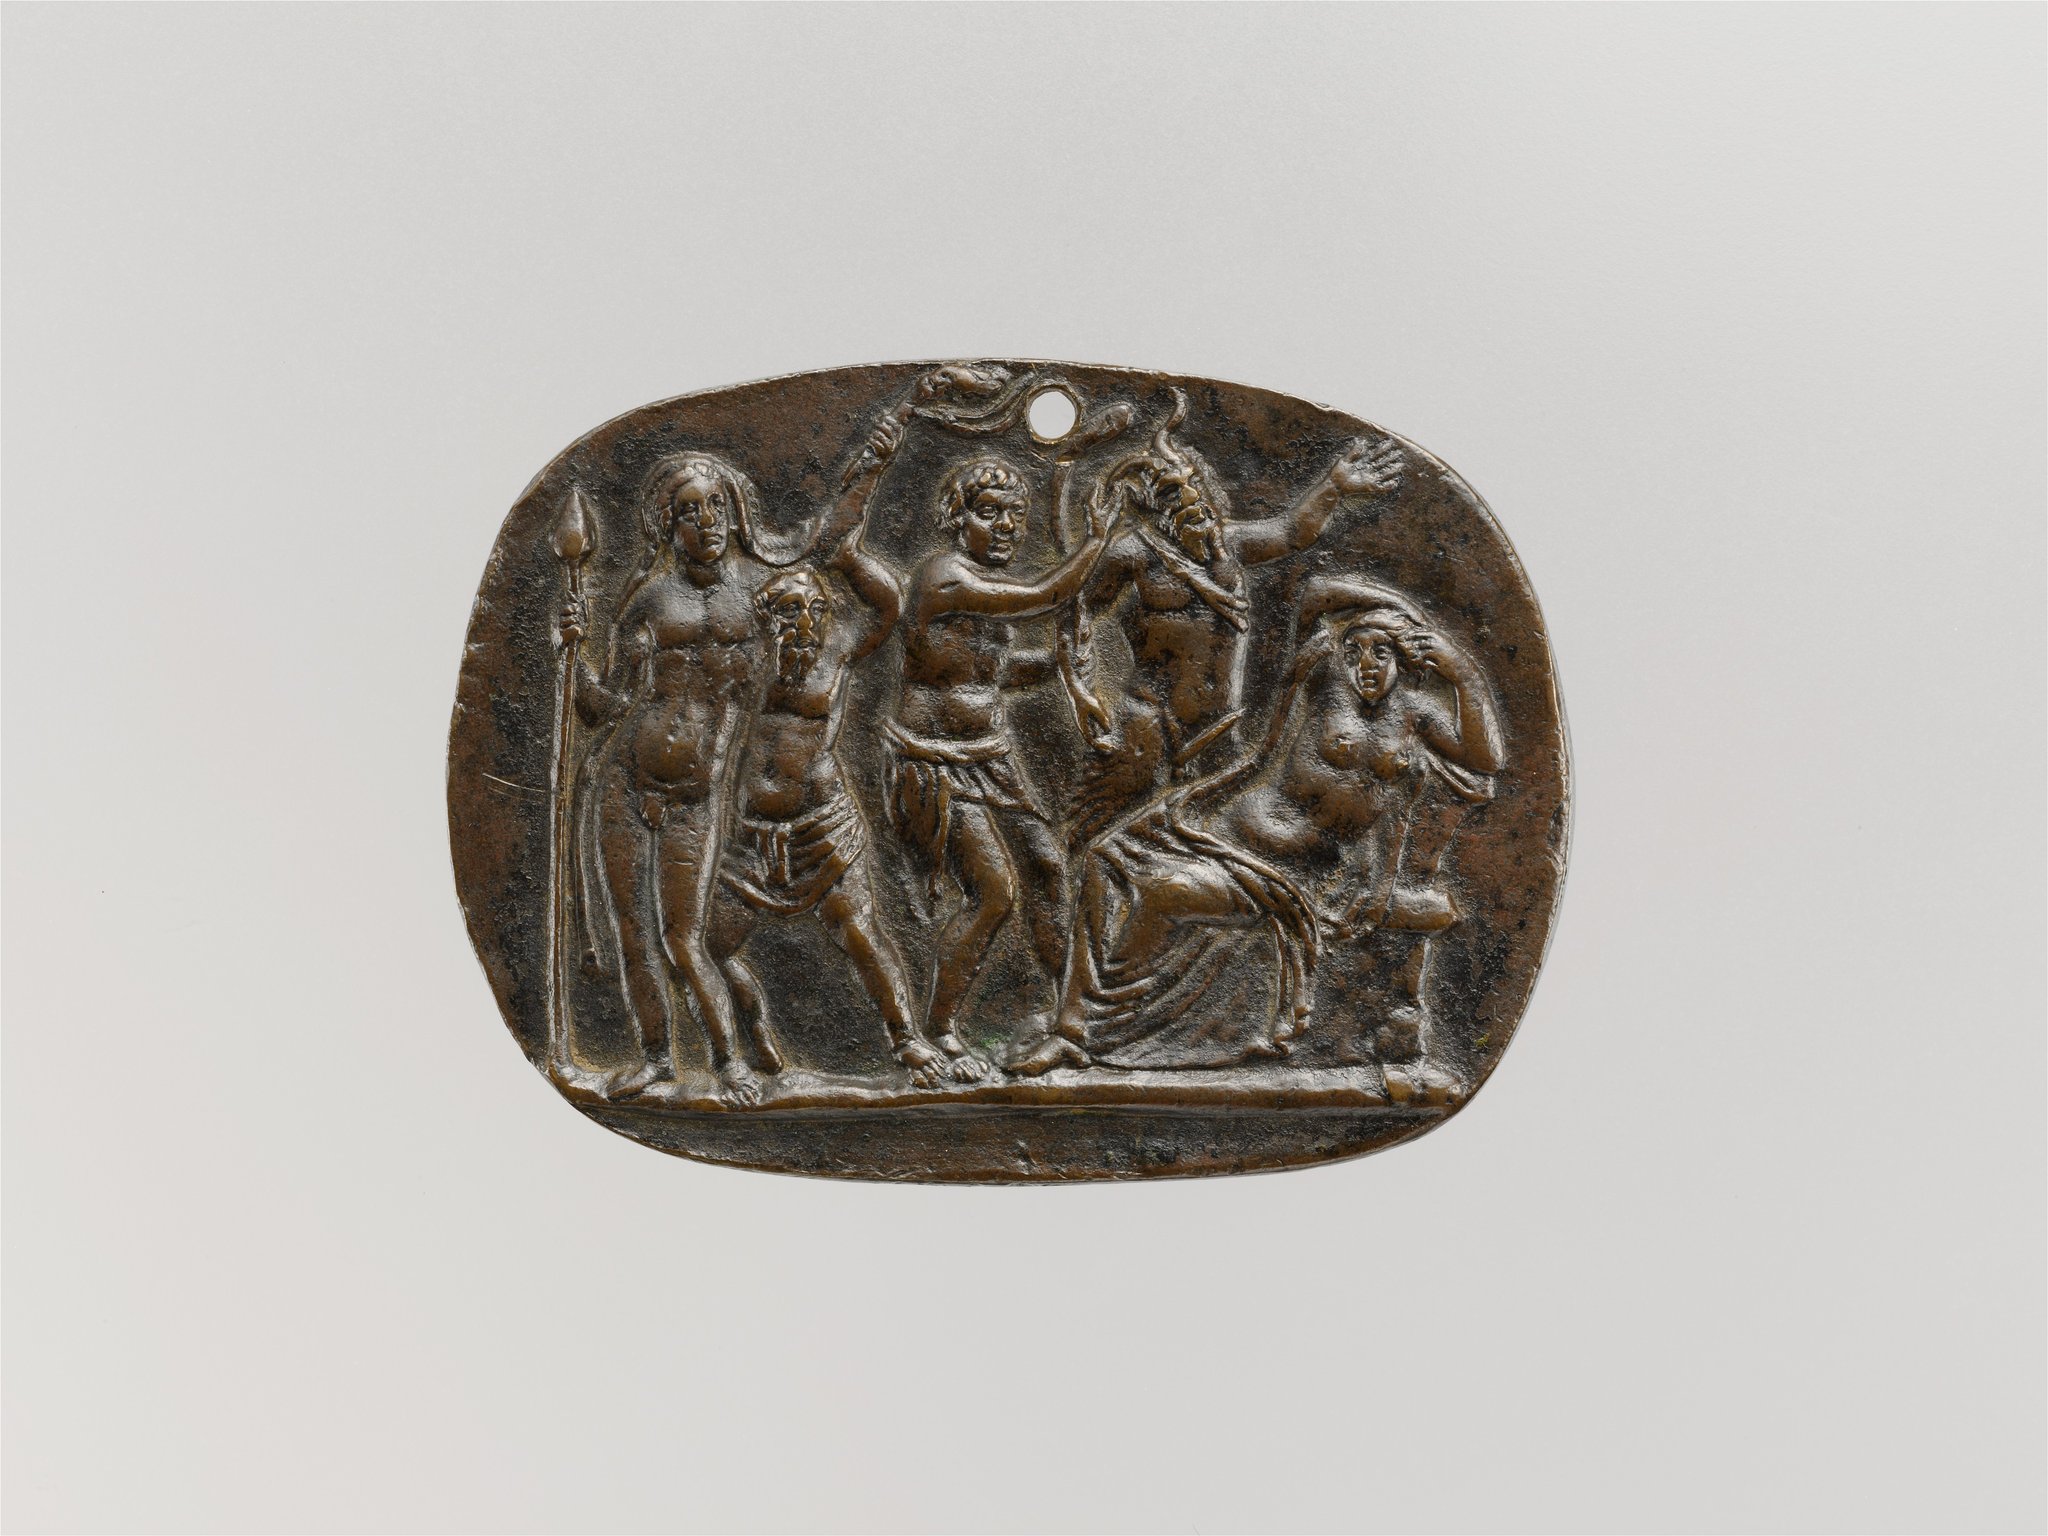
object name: plaquette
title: Bacchus discovering Ariadne on Naxos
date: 1401-1500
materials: bronze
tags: ariadne,bacchus